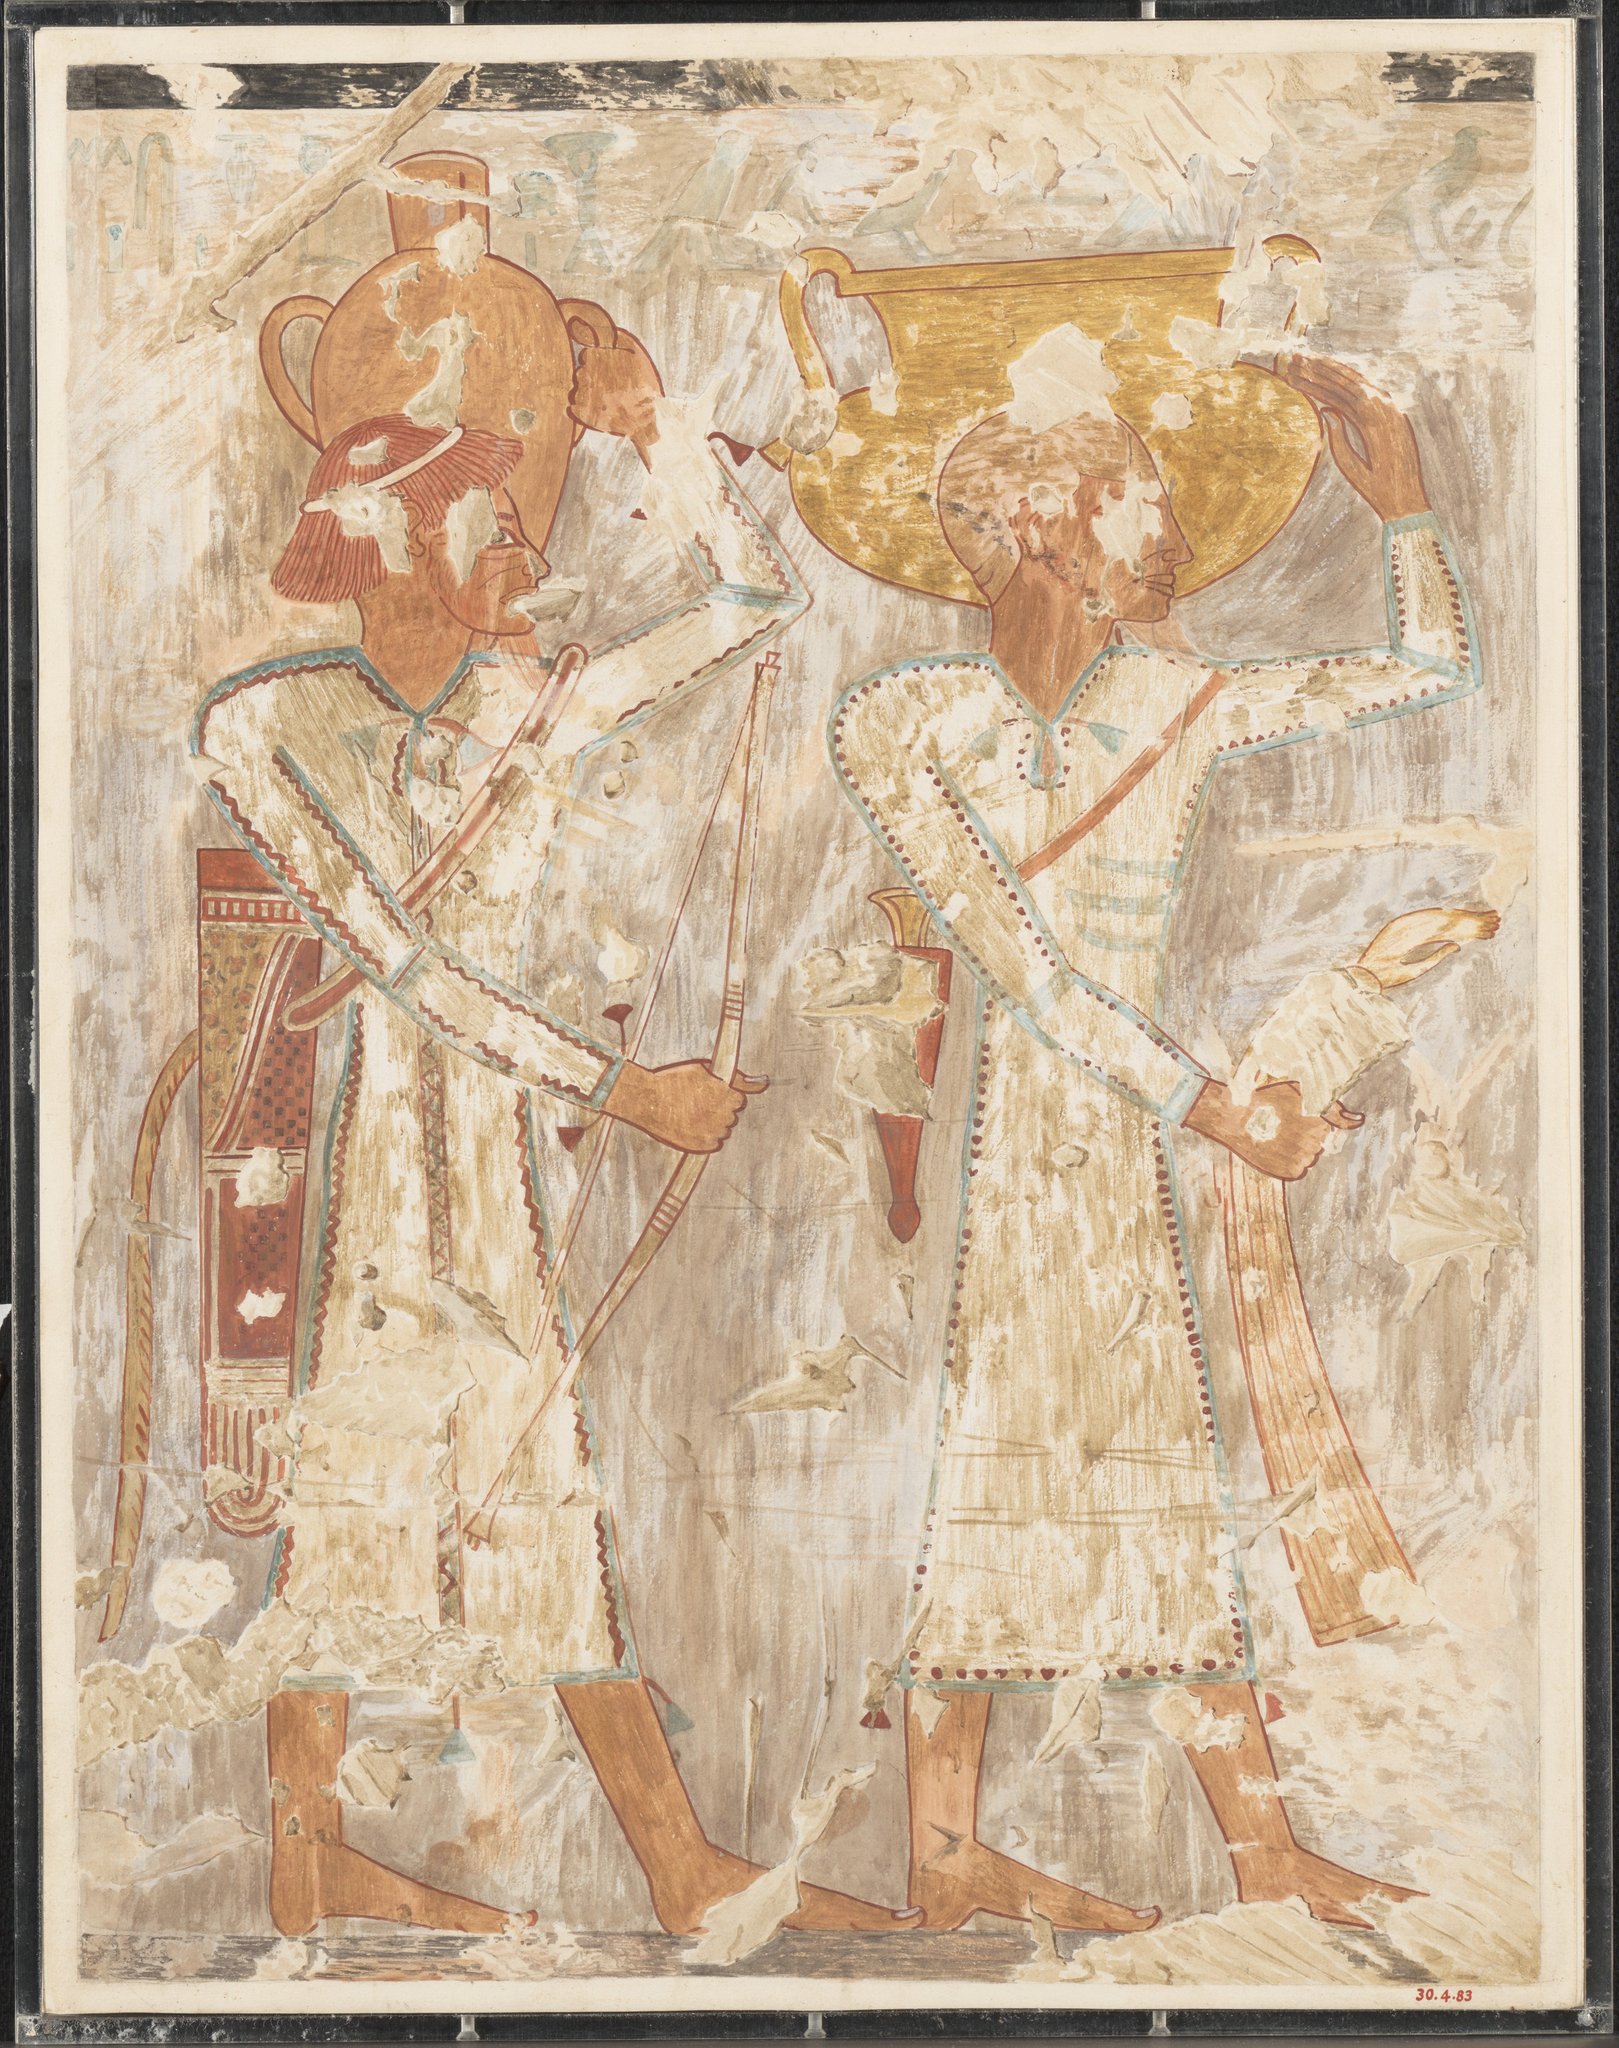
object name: facsimile, rekhmire tt 100, asian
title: Syrians Bringing Vessels and Weapons, Tomb of Rekhmire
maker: nina de garis davies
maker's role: artist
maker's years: 1881-1965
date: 1479-1425 BCE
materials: paper, paint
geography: egypt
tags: men